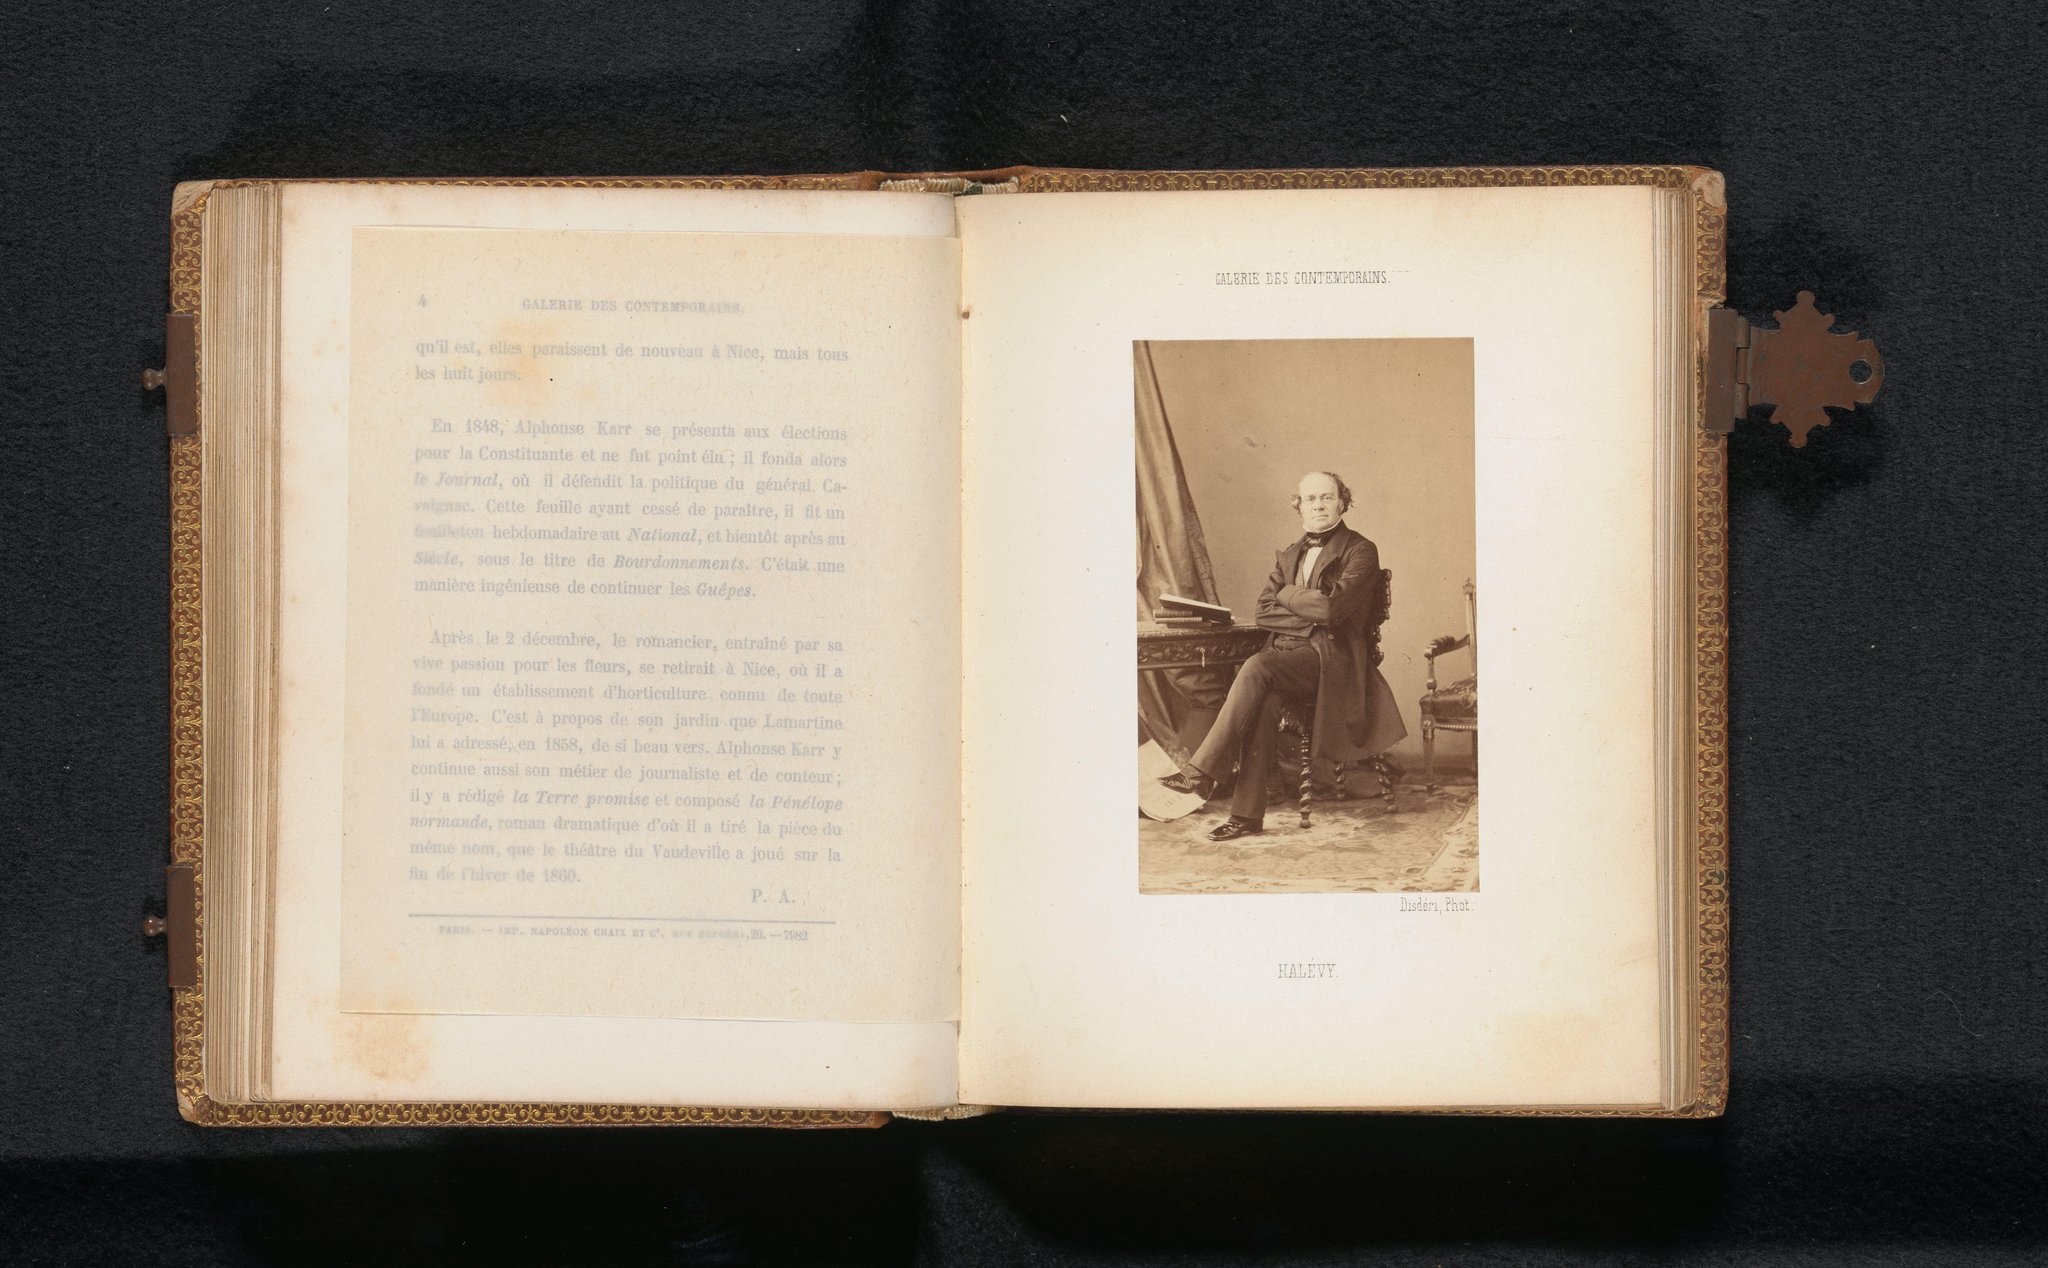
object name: page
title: Portret van Jacques Fromental Halévy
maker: andré-adolphe-eugène disdéri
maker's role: fotograaf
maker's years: 1819-1889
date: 1857-1862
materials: photographic support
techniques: albumen print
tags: paris, adult man, historical persons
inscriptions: inscription: ‘Galerie des Contemporains’